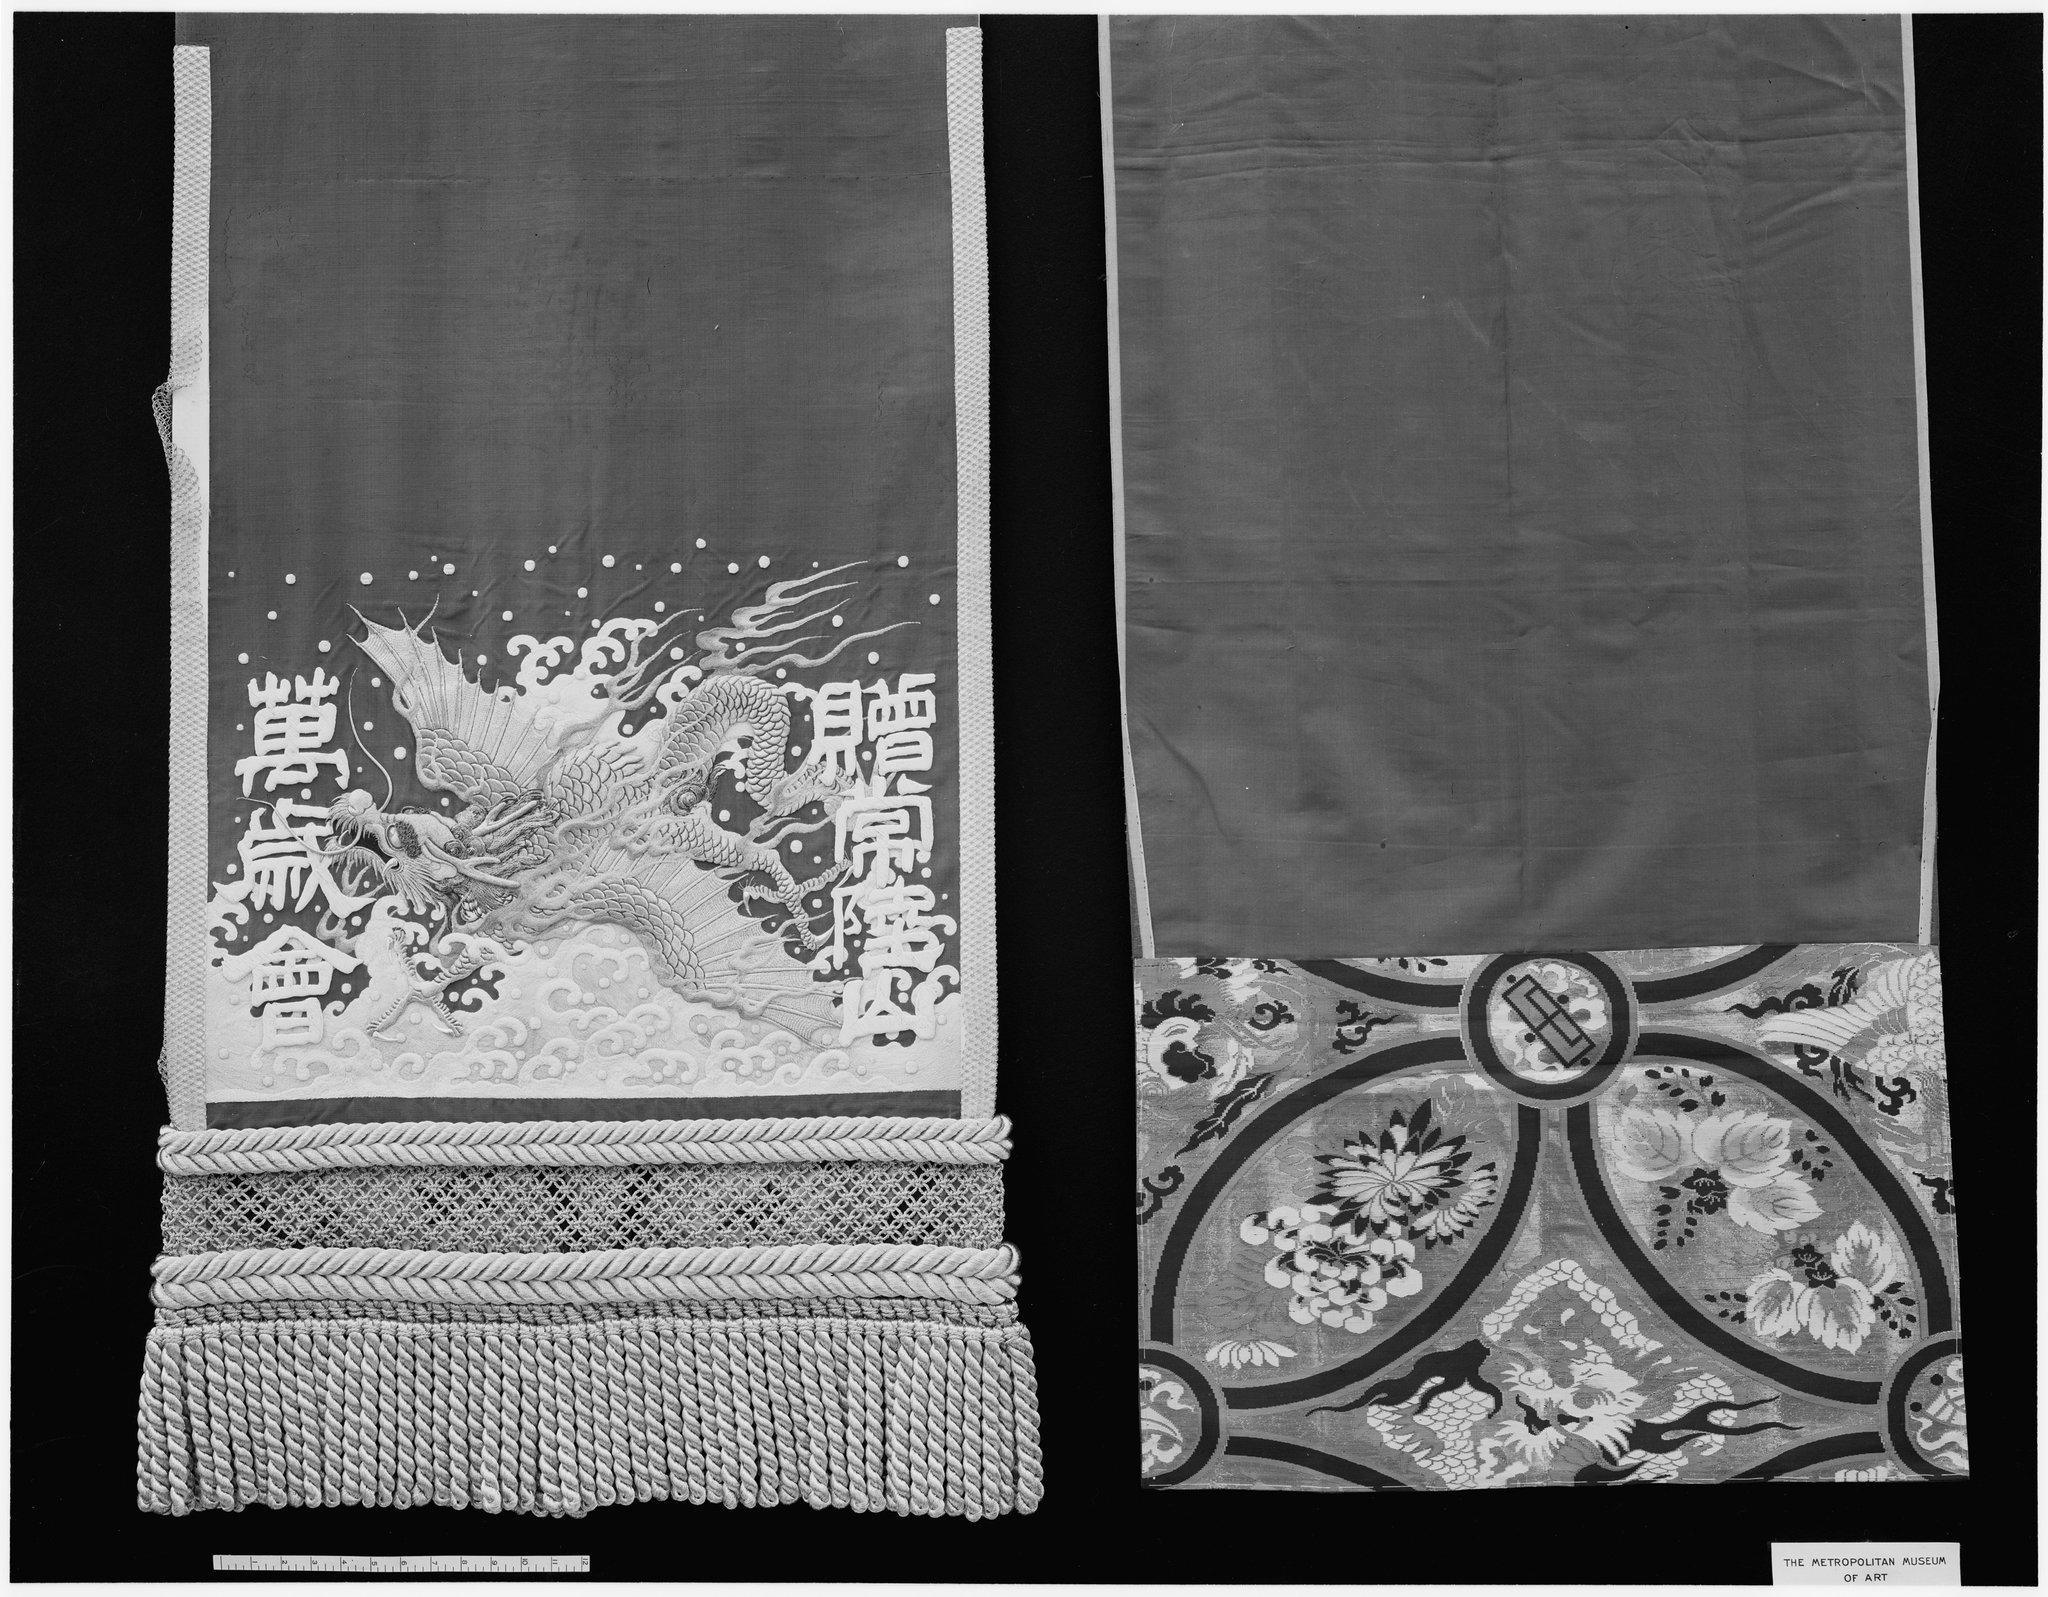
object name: sumo wrestler's ceremonial apron kesho mawashi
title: Sumo Wrestler's Ceremonial Apron (Kesho Mawashi)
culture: japanese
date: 1901-1933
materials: metal thread, silk, velvet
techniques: embroidery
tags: dragons,flowers,leaves